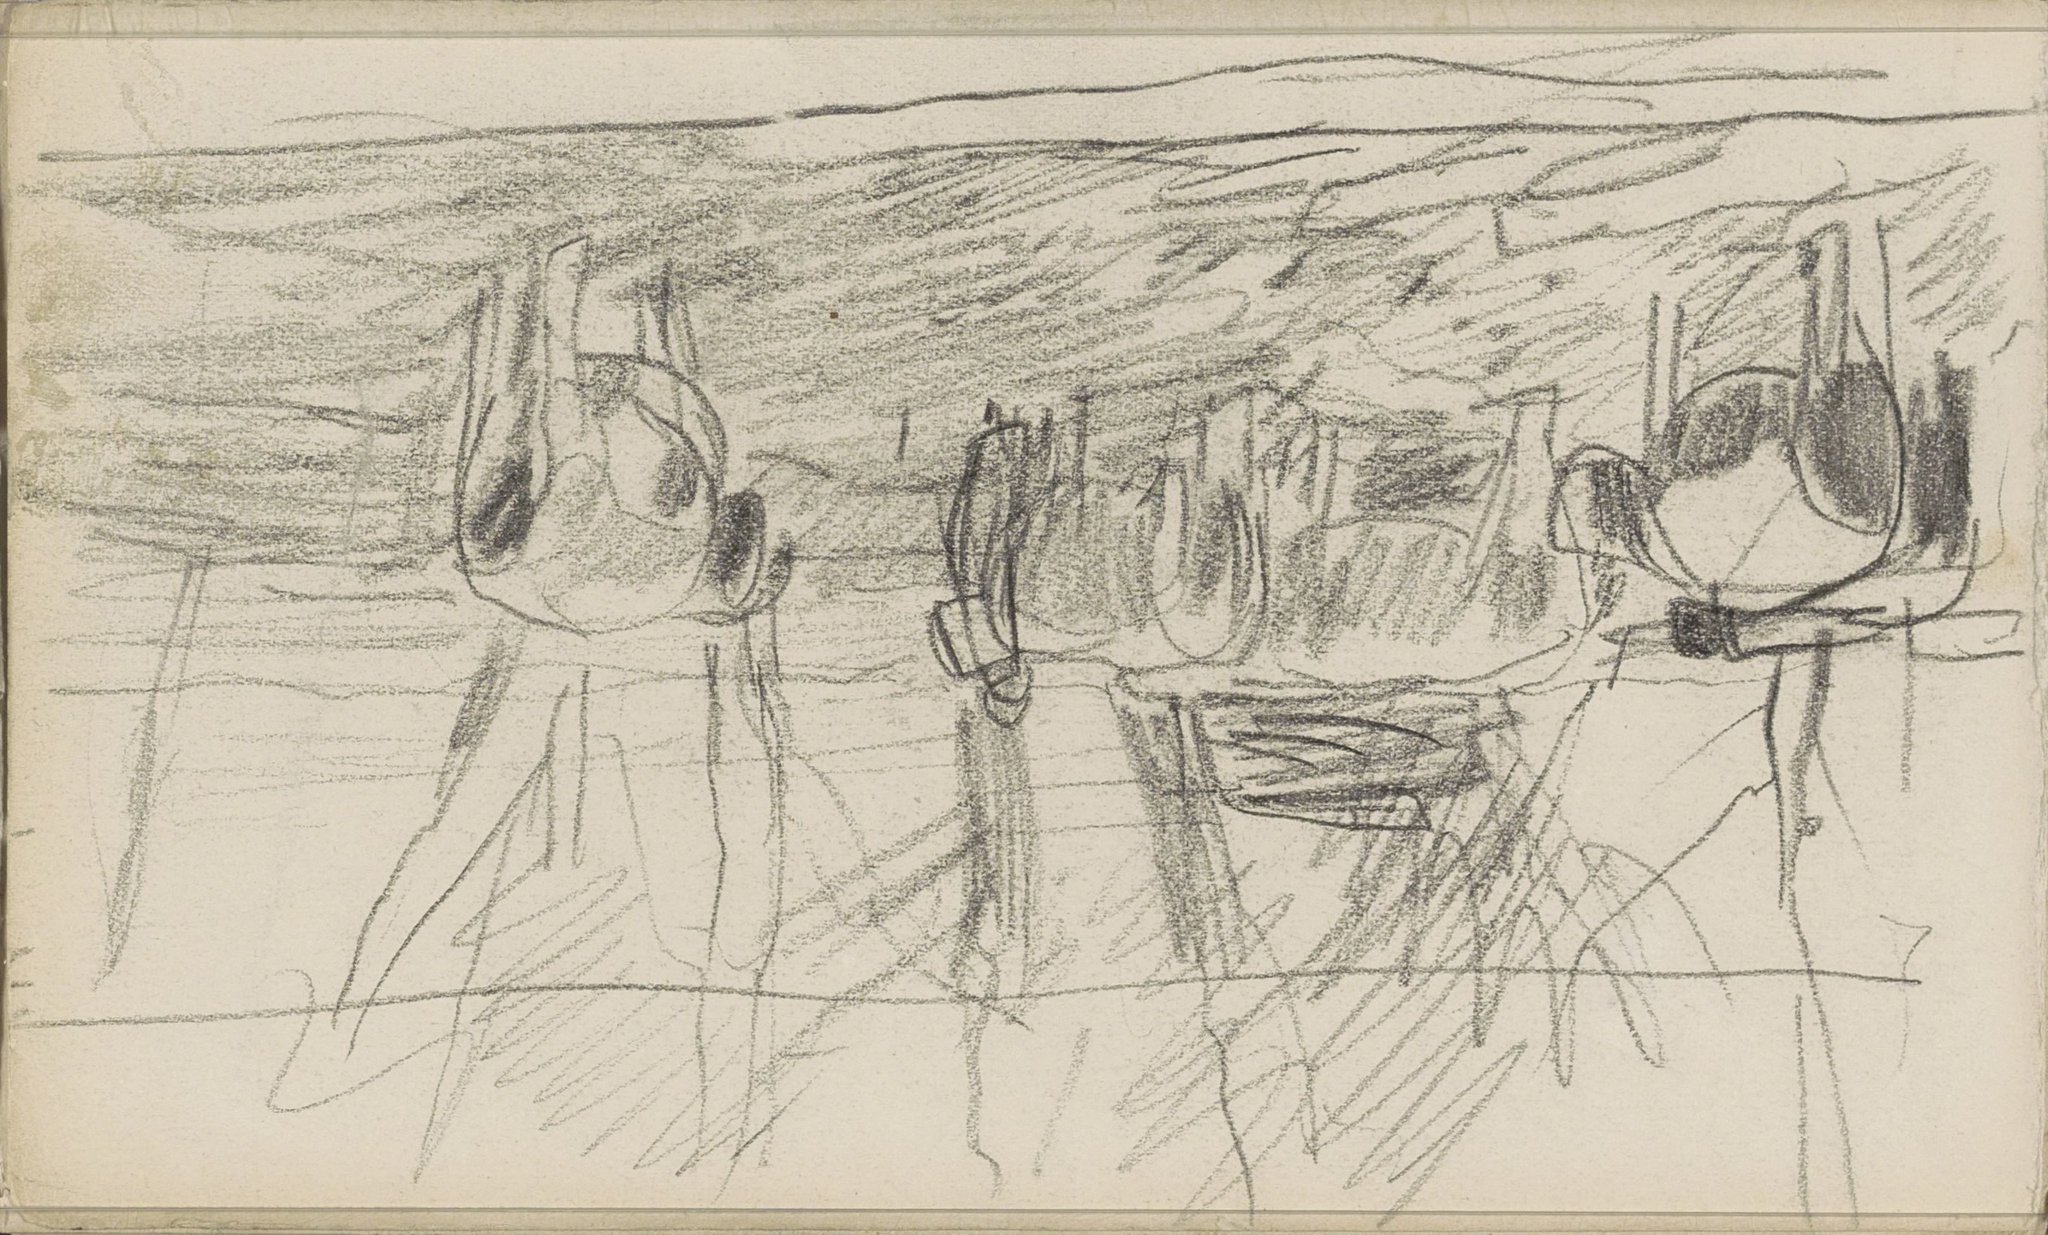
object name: sketchbook leaf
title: Koeien in een weiland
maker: anton mauve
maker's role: draughtsman, painter, print maker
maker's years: 1838-1888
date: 1848-1888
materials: chalk, paper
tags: cow, meadow, pasture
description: Blad 19 recto uit een schetsboek met 33 bladen.